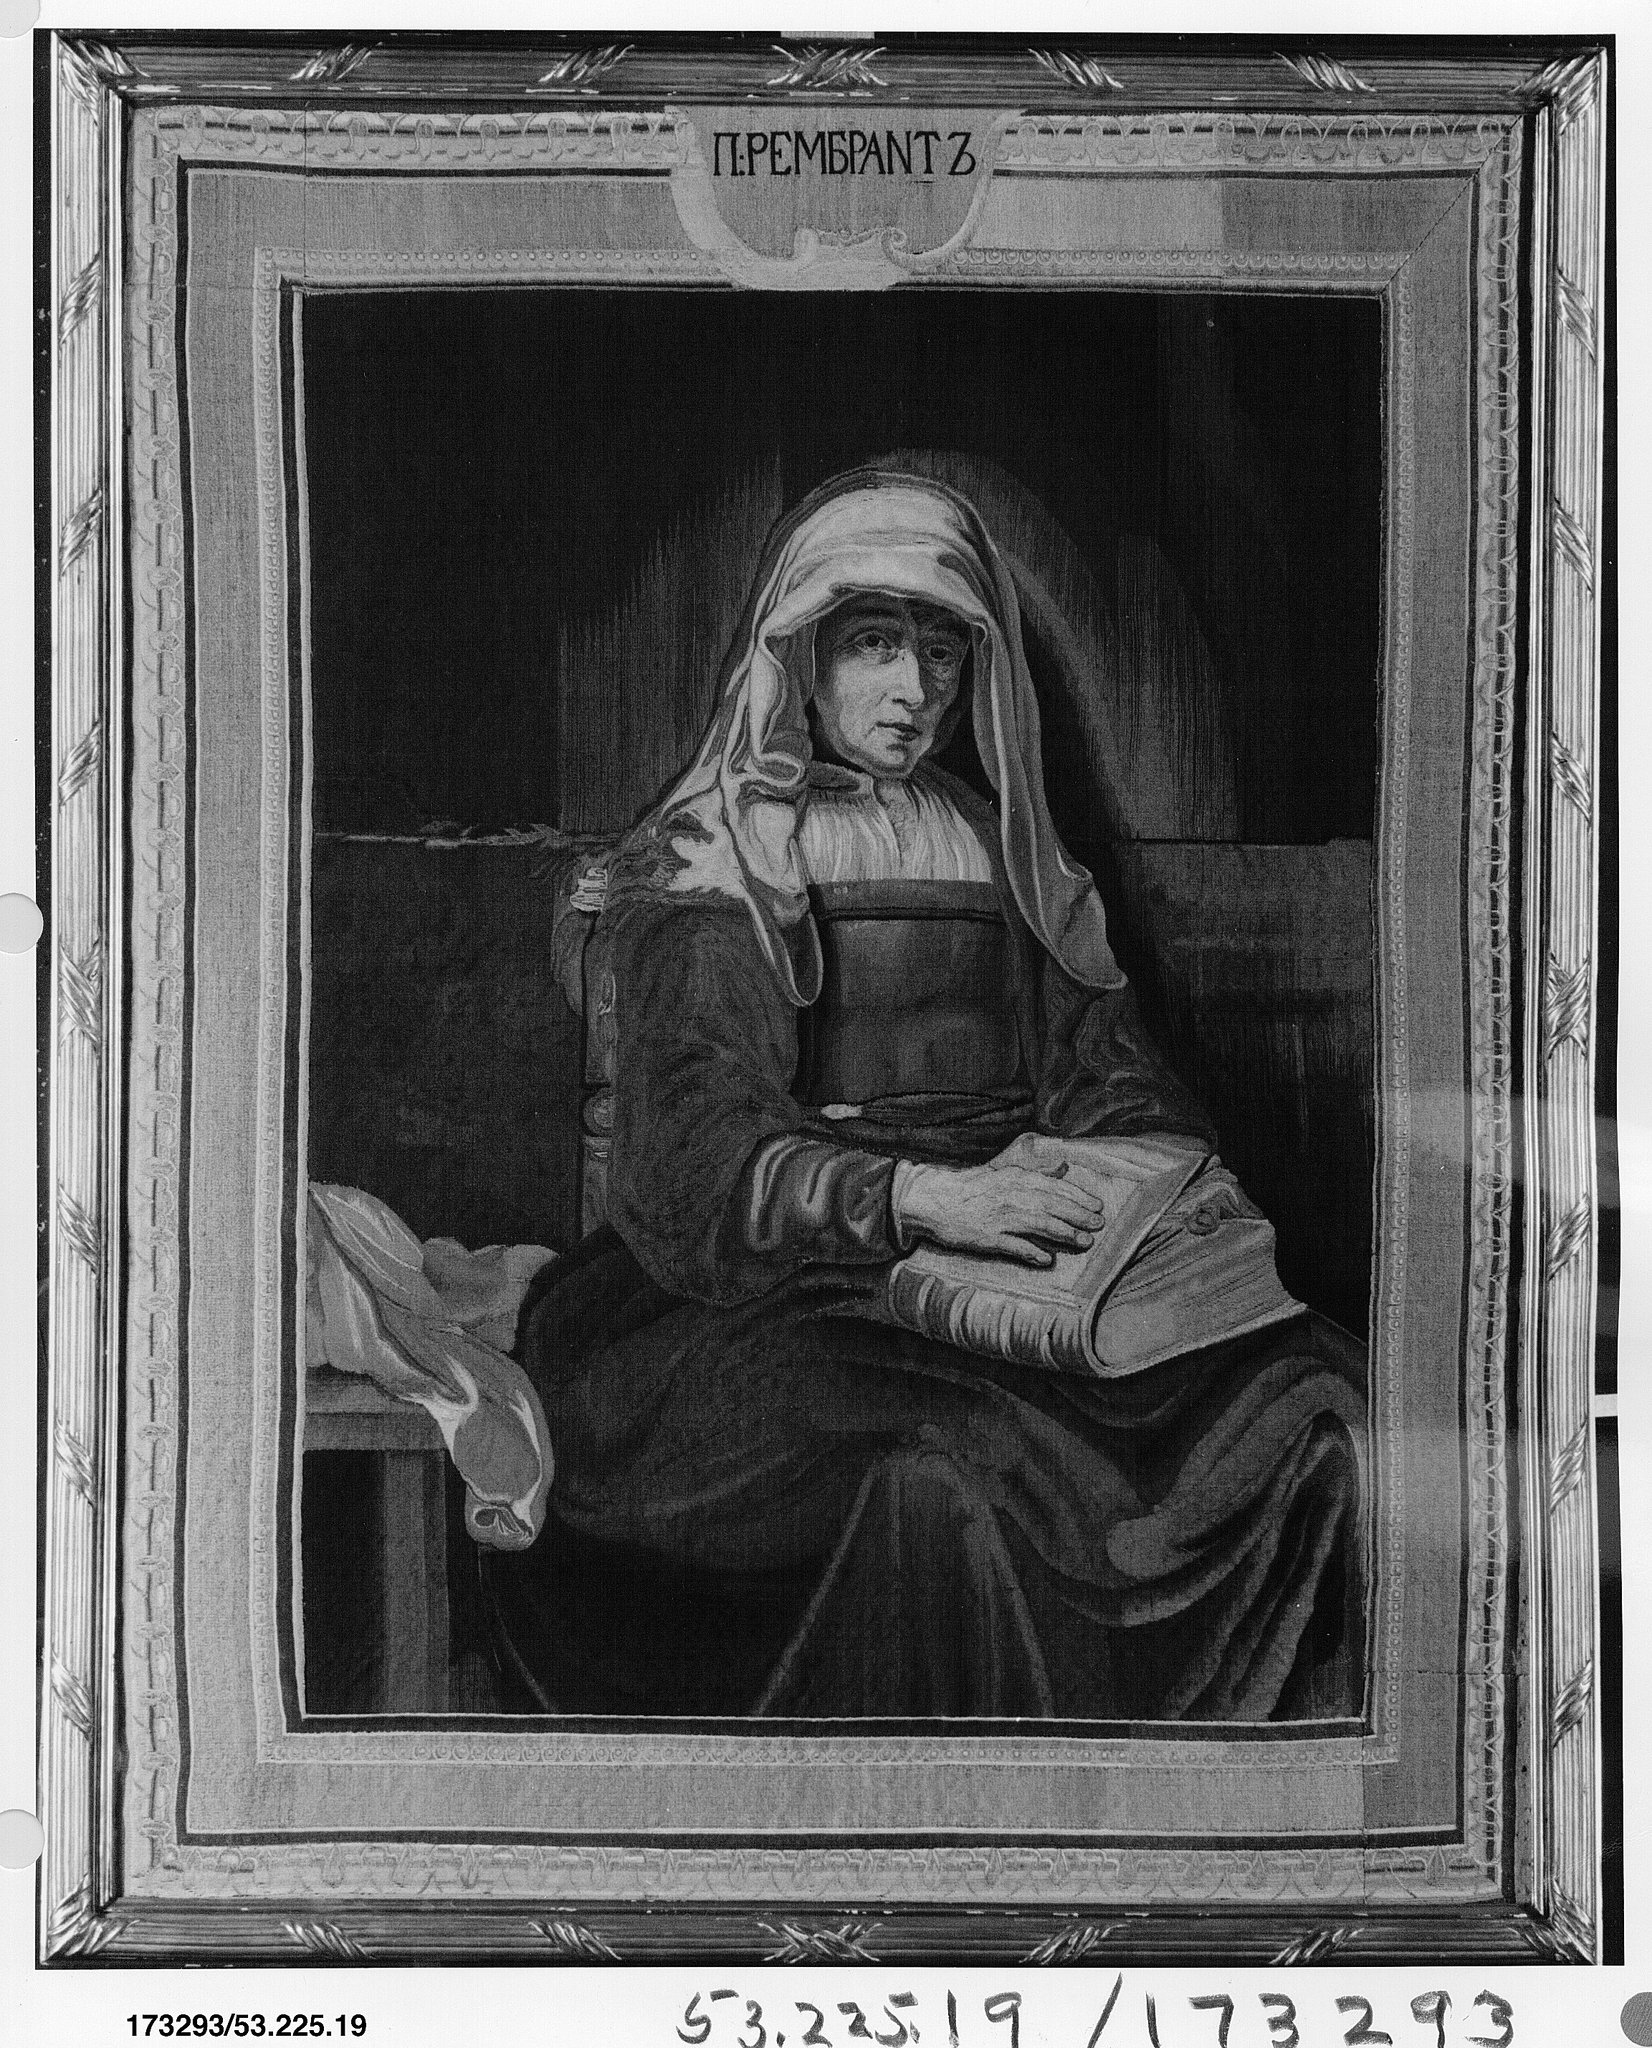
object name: tapestry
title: Old Woman with a Book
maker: imperial russian tapestry manufactory, saint petersburg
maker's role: manufactory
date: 1767-1800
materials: metal thread, wool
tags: books,women